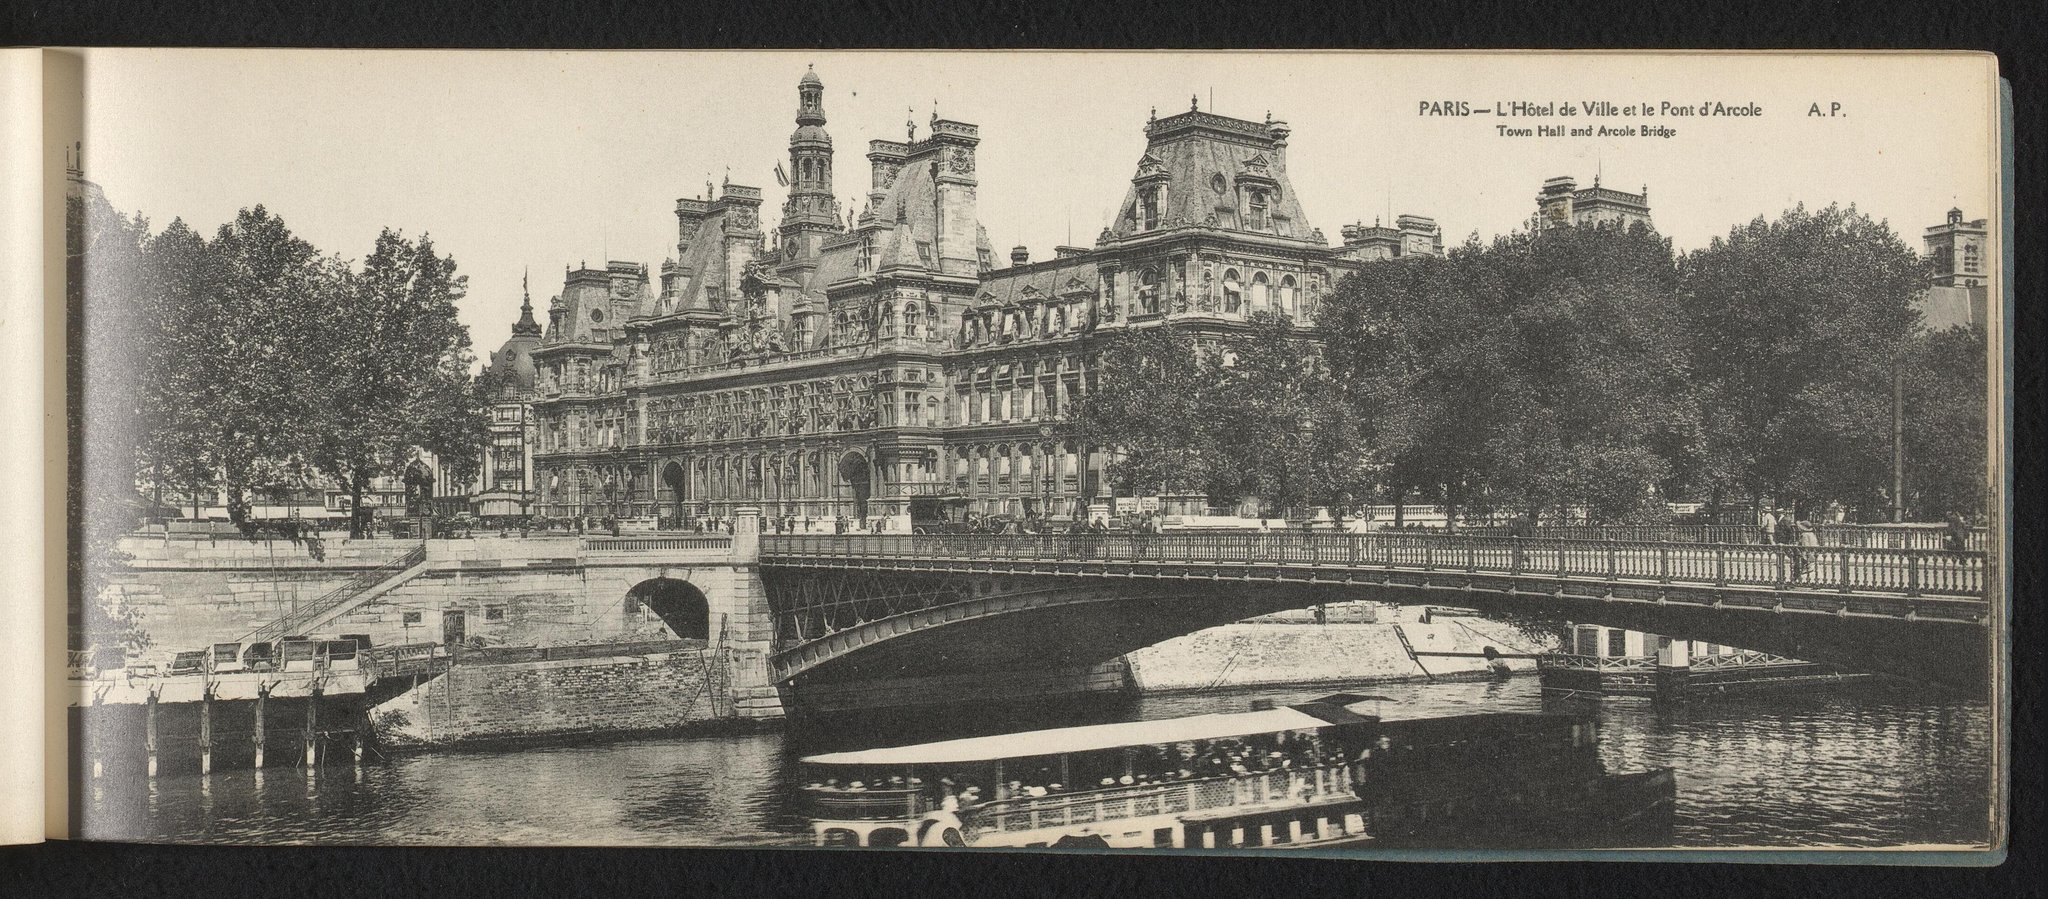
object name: photomechanical print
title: Paris. L'Hôtel de Ville et le Pont d'Arcole / Town Hall and Arcole Bridge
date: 1910-1925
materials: cardboard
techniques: photograph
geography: paris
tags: bridge in city across river, canal, etc. (+ city(-scape) with figures, staffage), townhall